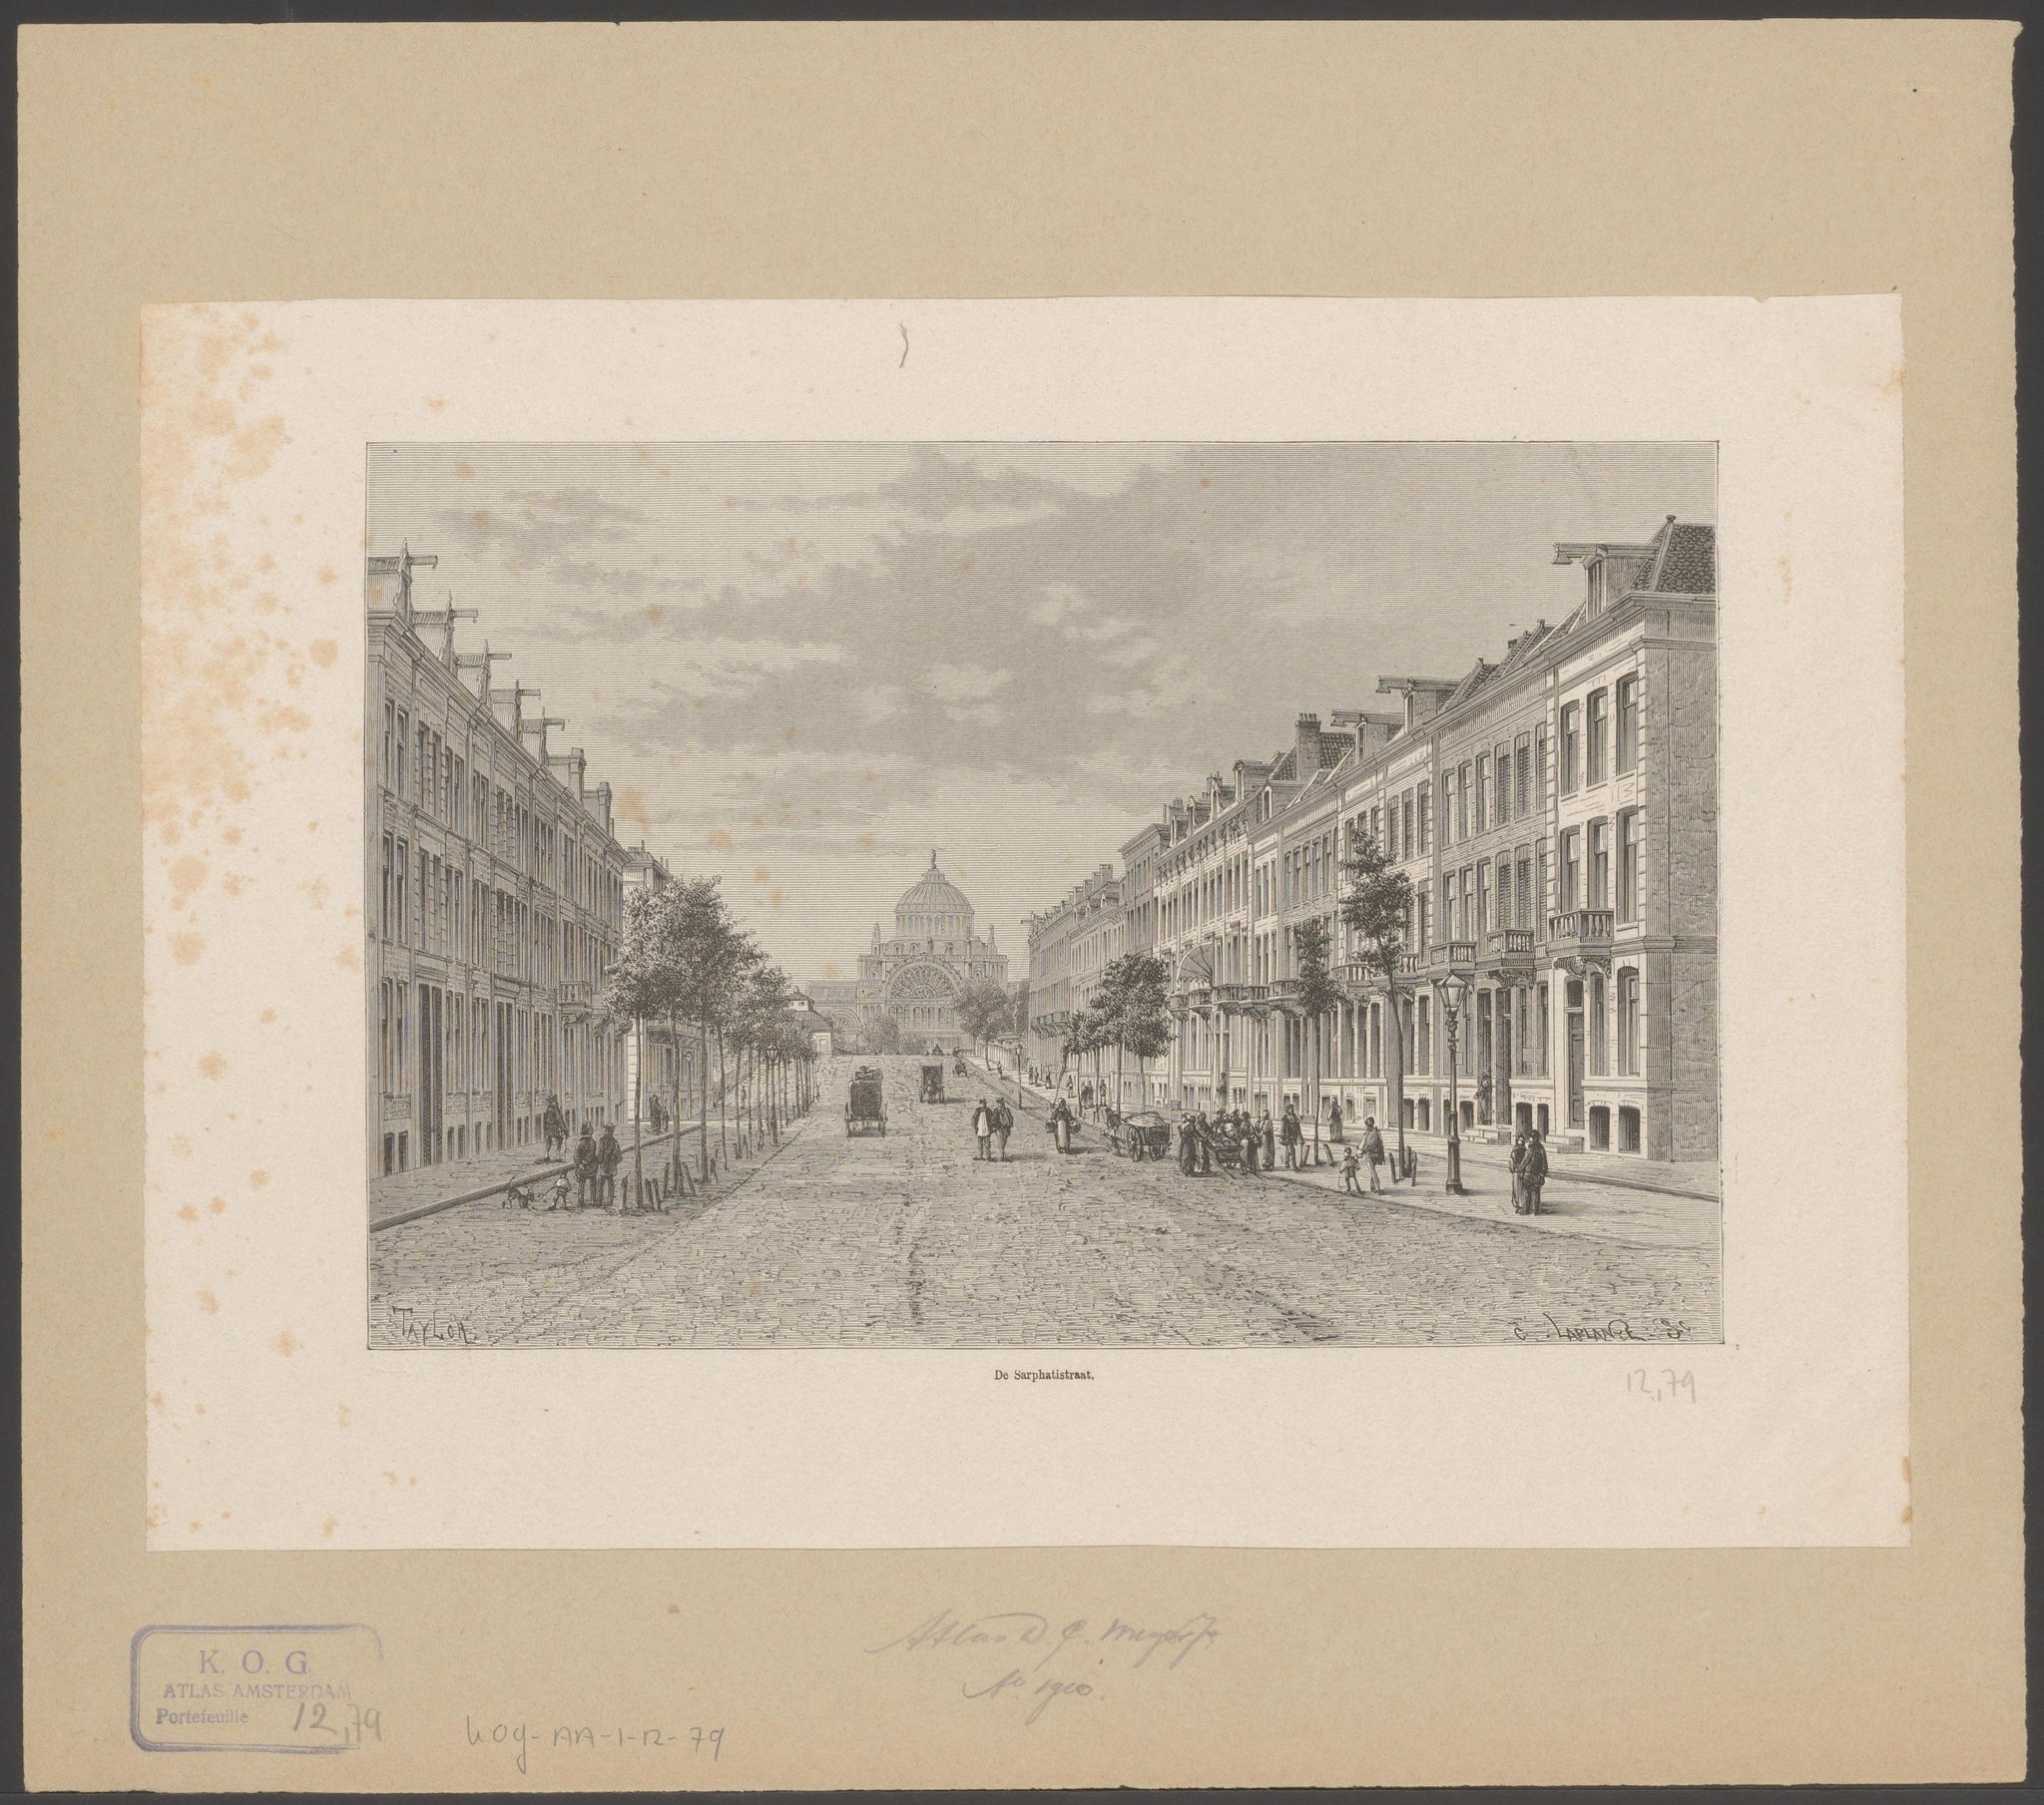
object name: print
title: Gezicht op het Paleis voor Volksvlijt vanaf de Sarphatistraat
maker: charles laplante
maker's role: print maker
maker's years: -1903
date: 1850-1903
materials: paper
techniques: letterpress printing, engraving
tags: city-view in general; 'veduta', permanent exhibition, museum, the usual house or row of houses, street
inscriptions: collector's mark: ‘12,79’ Lugt 1641b, inscription: ‘Atlas D.C.Meyer Jr / Ao 1910.’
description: Onderwerpsrubriek binnen de Atlas Amsterdam: Sarphatistraat, Schans.